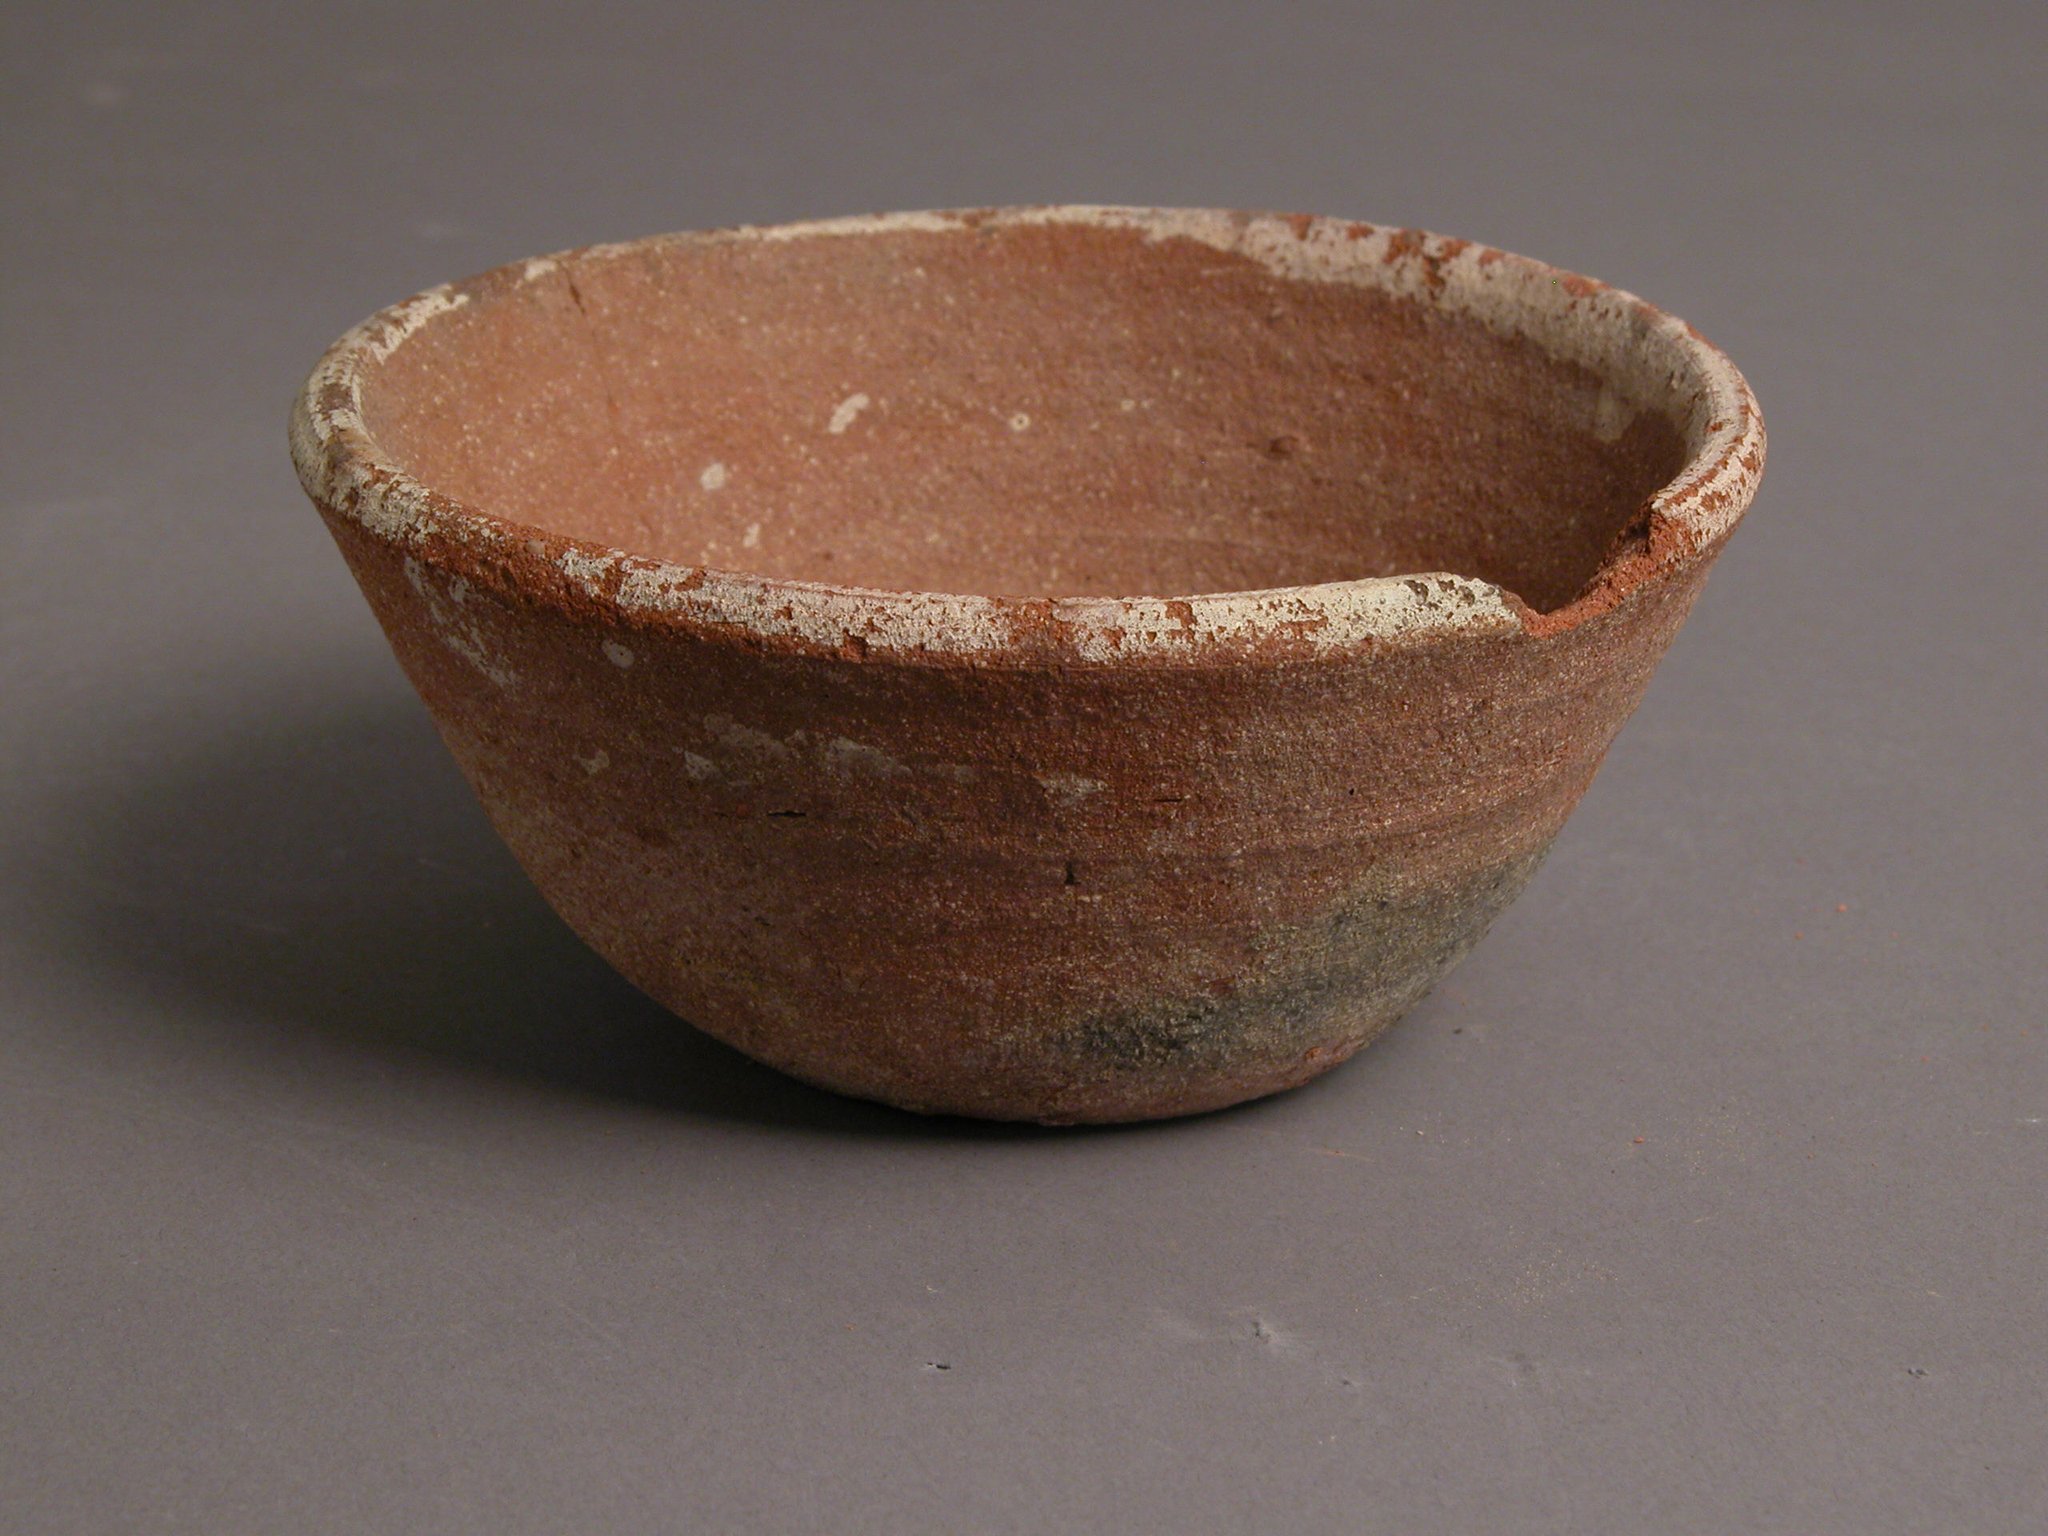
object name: bowl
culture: coptic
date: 301-700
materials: earthenware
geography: egypt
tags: bowls